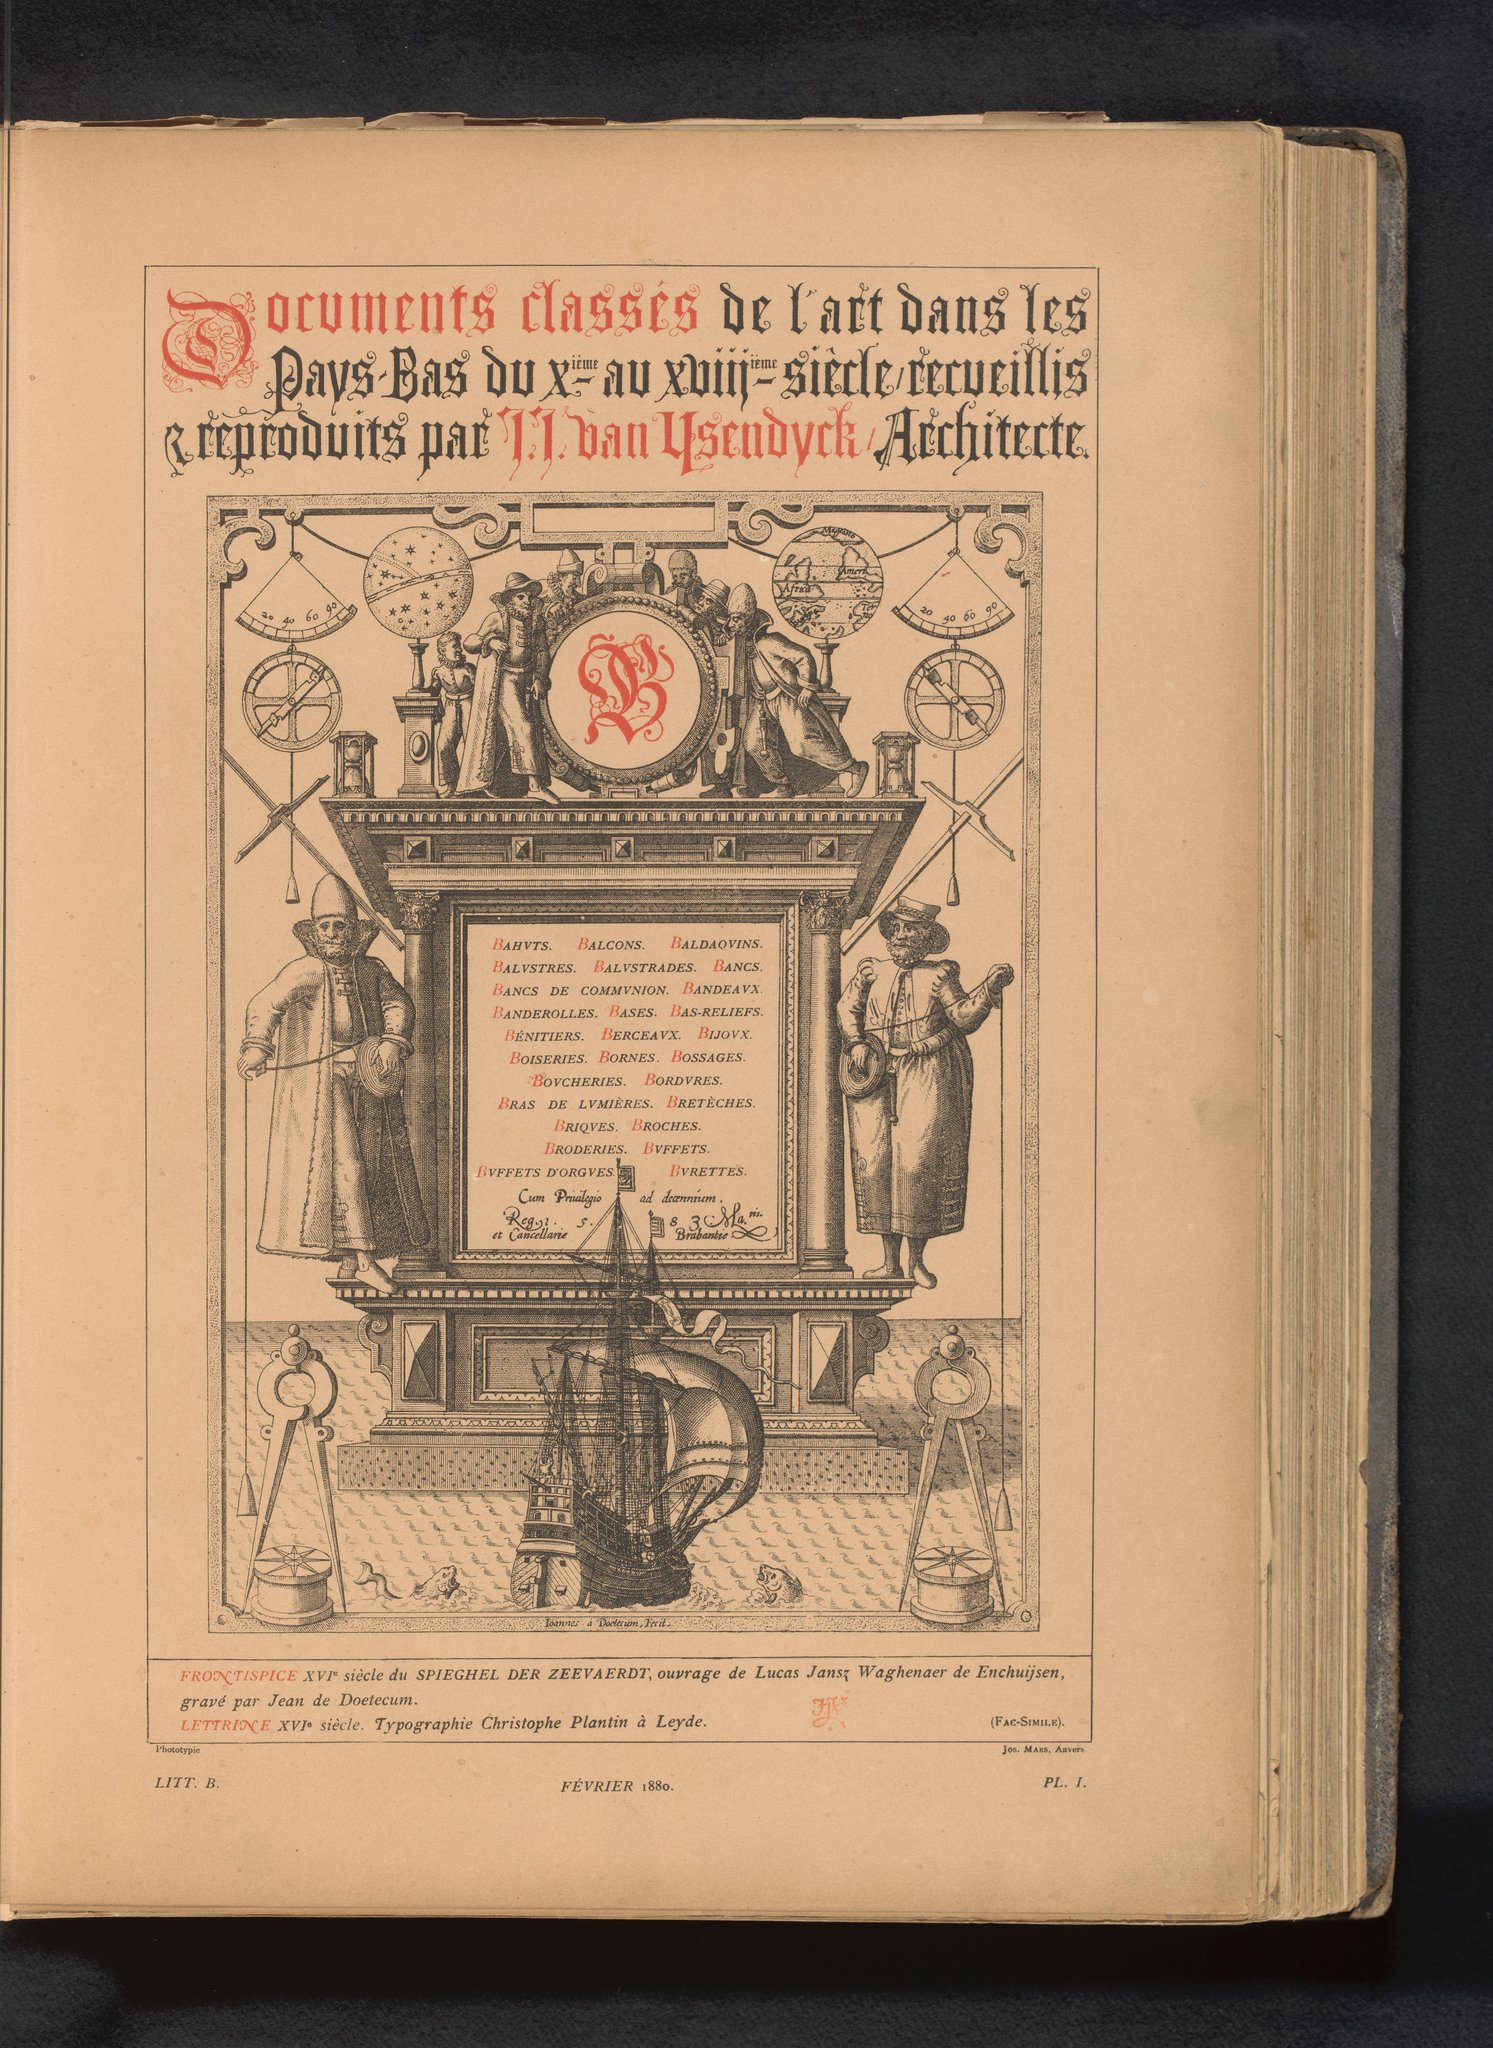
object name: photomechanical print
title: Reproductie van een titelpagina met zeevaart instrumenten door Johannes van Doetecum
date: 1875-1880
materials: paper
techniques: photolithography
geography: antwerp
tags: title-page, position-finding at sea; nautical instruments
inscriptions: inscription: ‘LITT: B. - PL. 1.’, monogram: ‘JJvY’